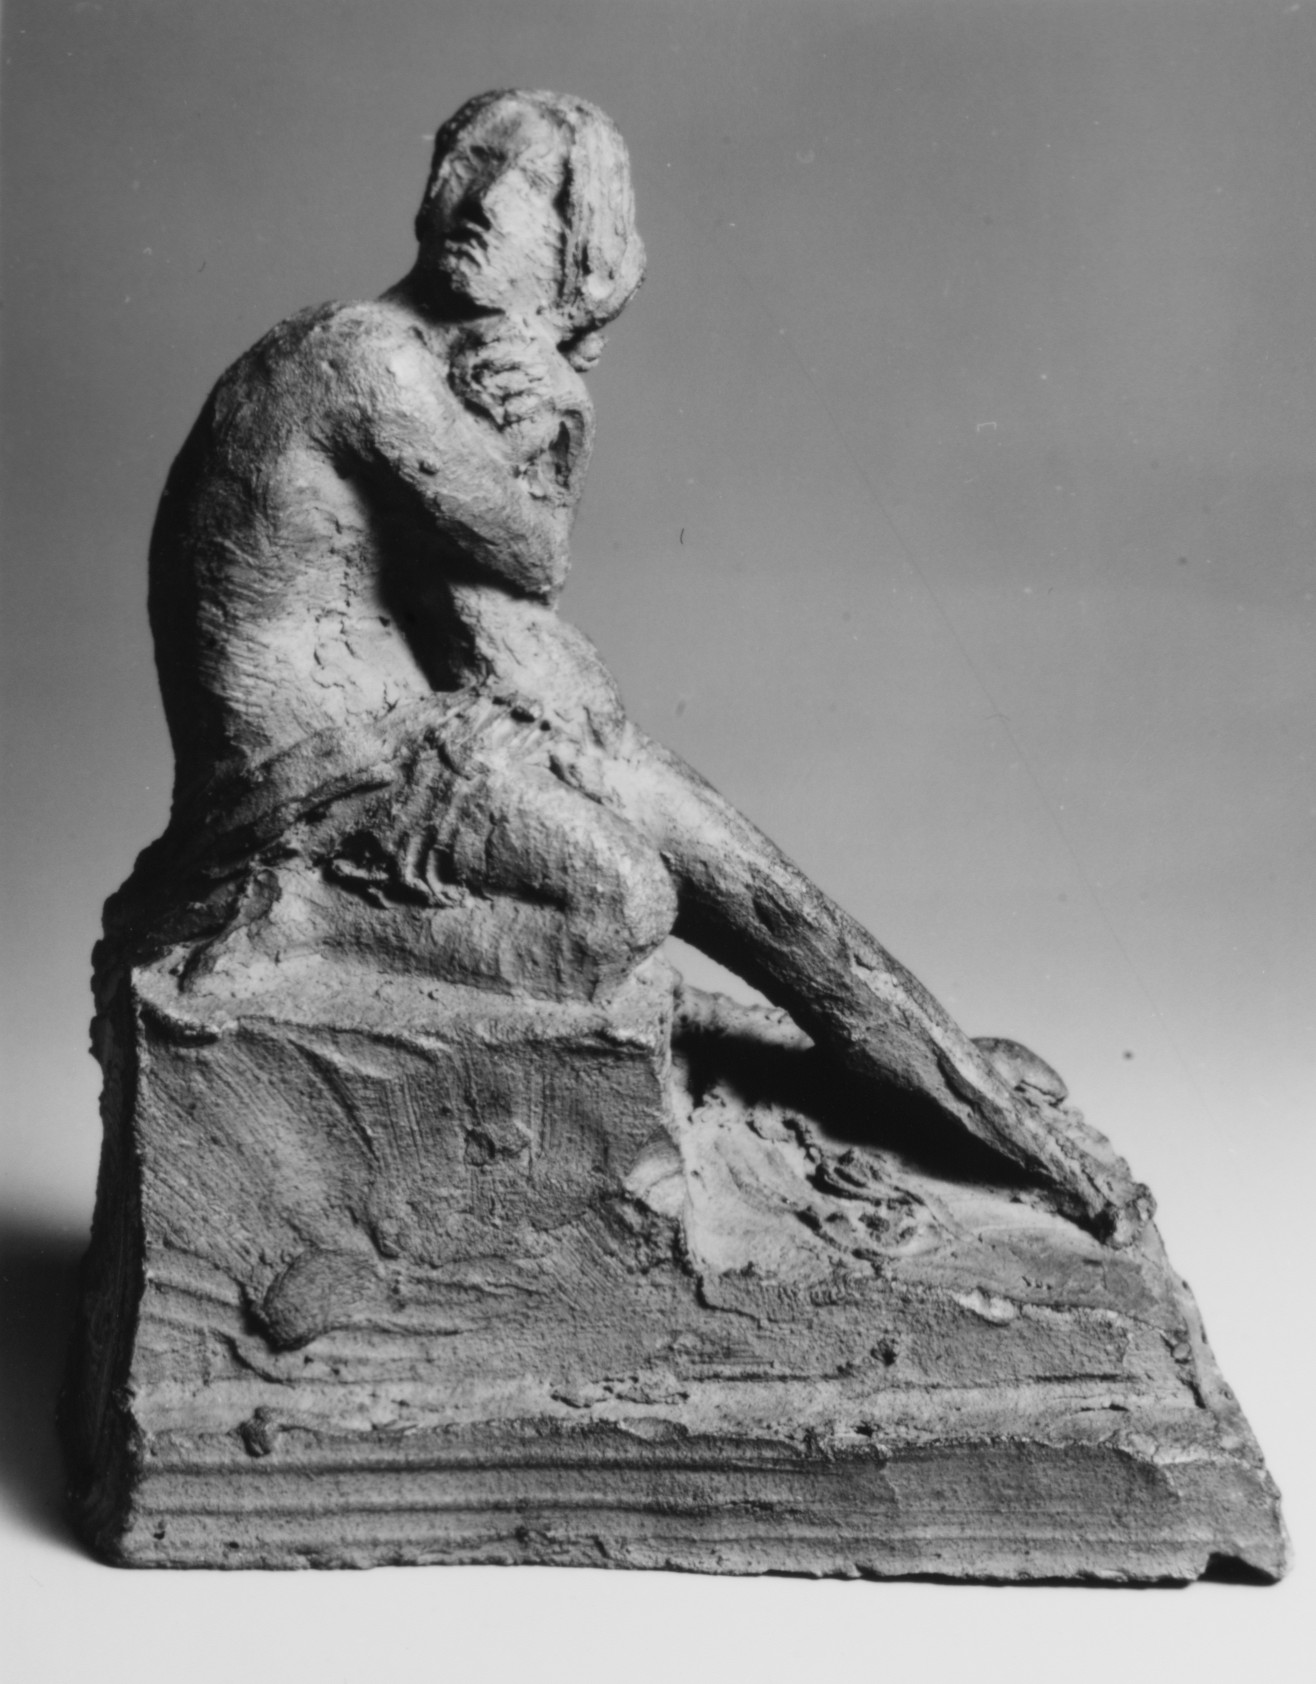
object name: statuette group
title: Woman with two children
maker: pierre jean david d'angers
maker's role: artist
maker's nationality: french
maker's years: 1788-1856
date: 1821-1833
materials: terracotta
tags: children,women